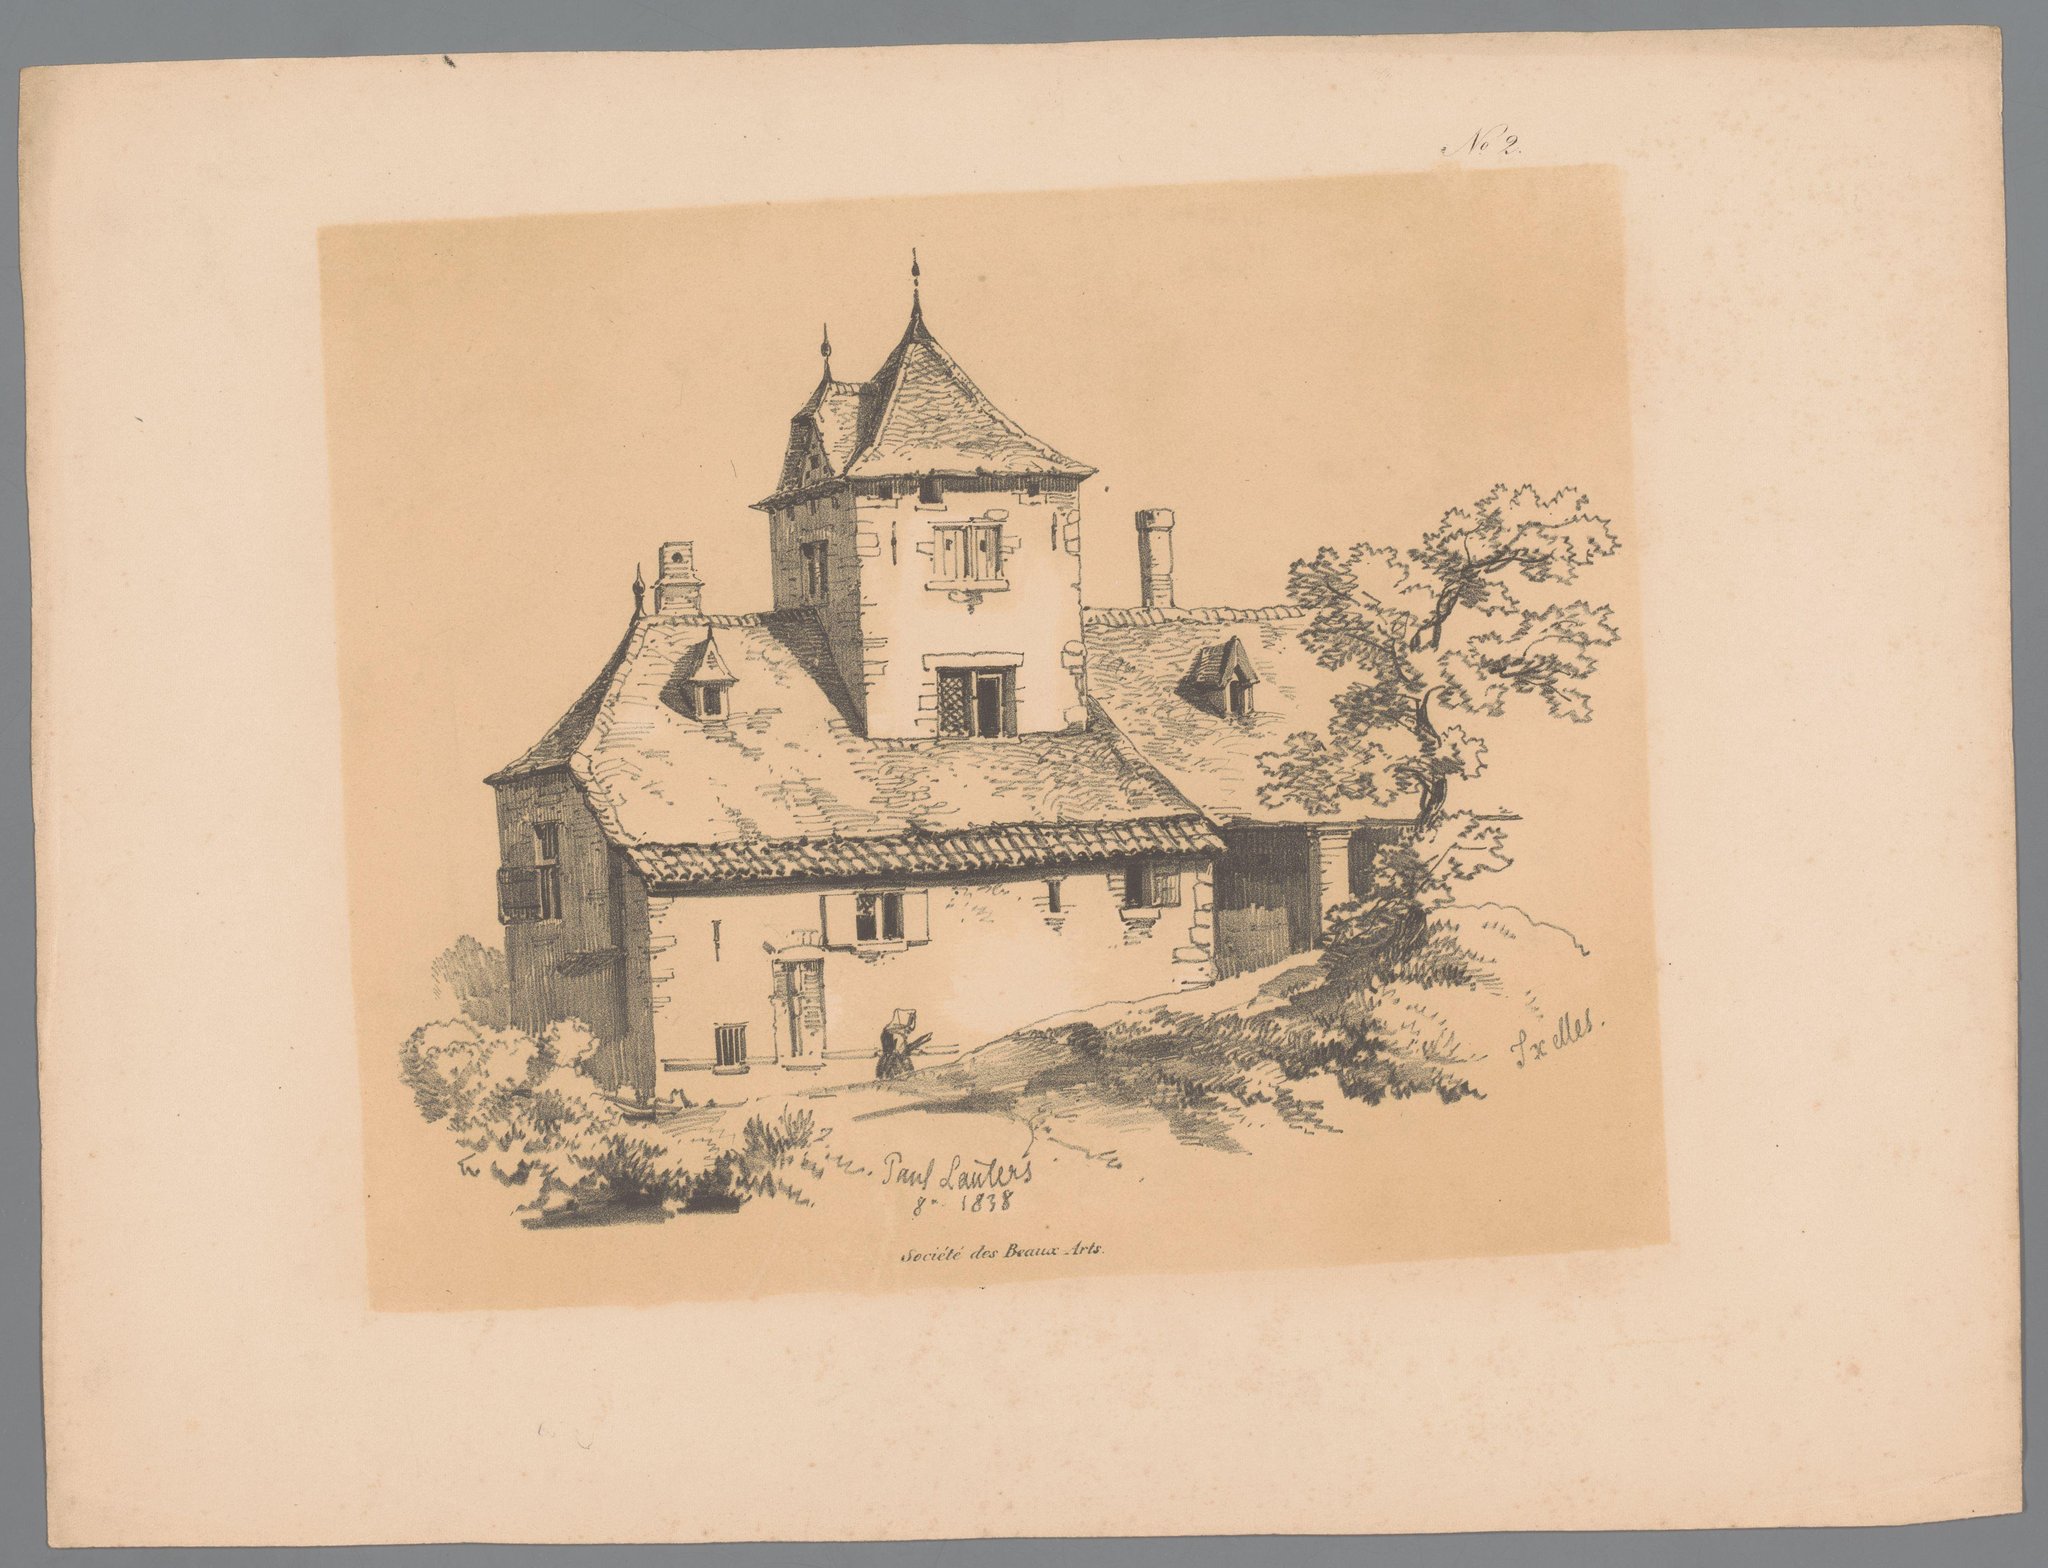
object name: print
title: Pittoreske gezichten door Paulus Lauters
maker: paulus lauters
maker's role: print maker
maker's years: 1806-1875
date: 1838-1839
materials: paper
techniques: tone lithography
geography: brussels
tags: rural housing, e.g. country-house, villa, cottage